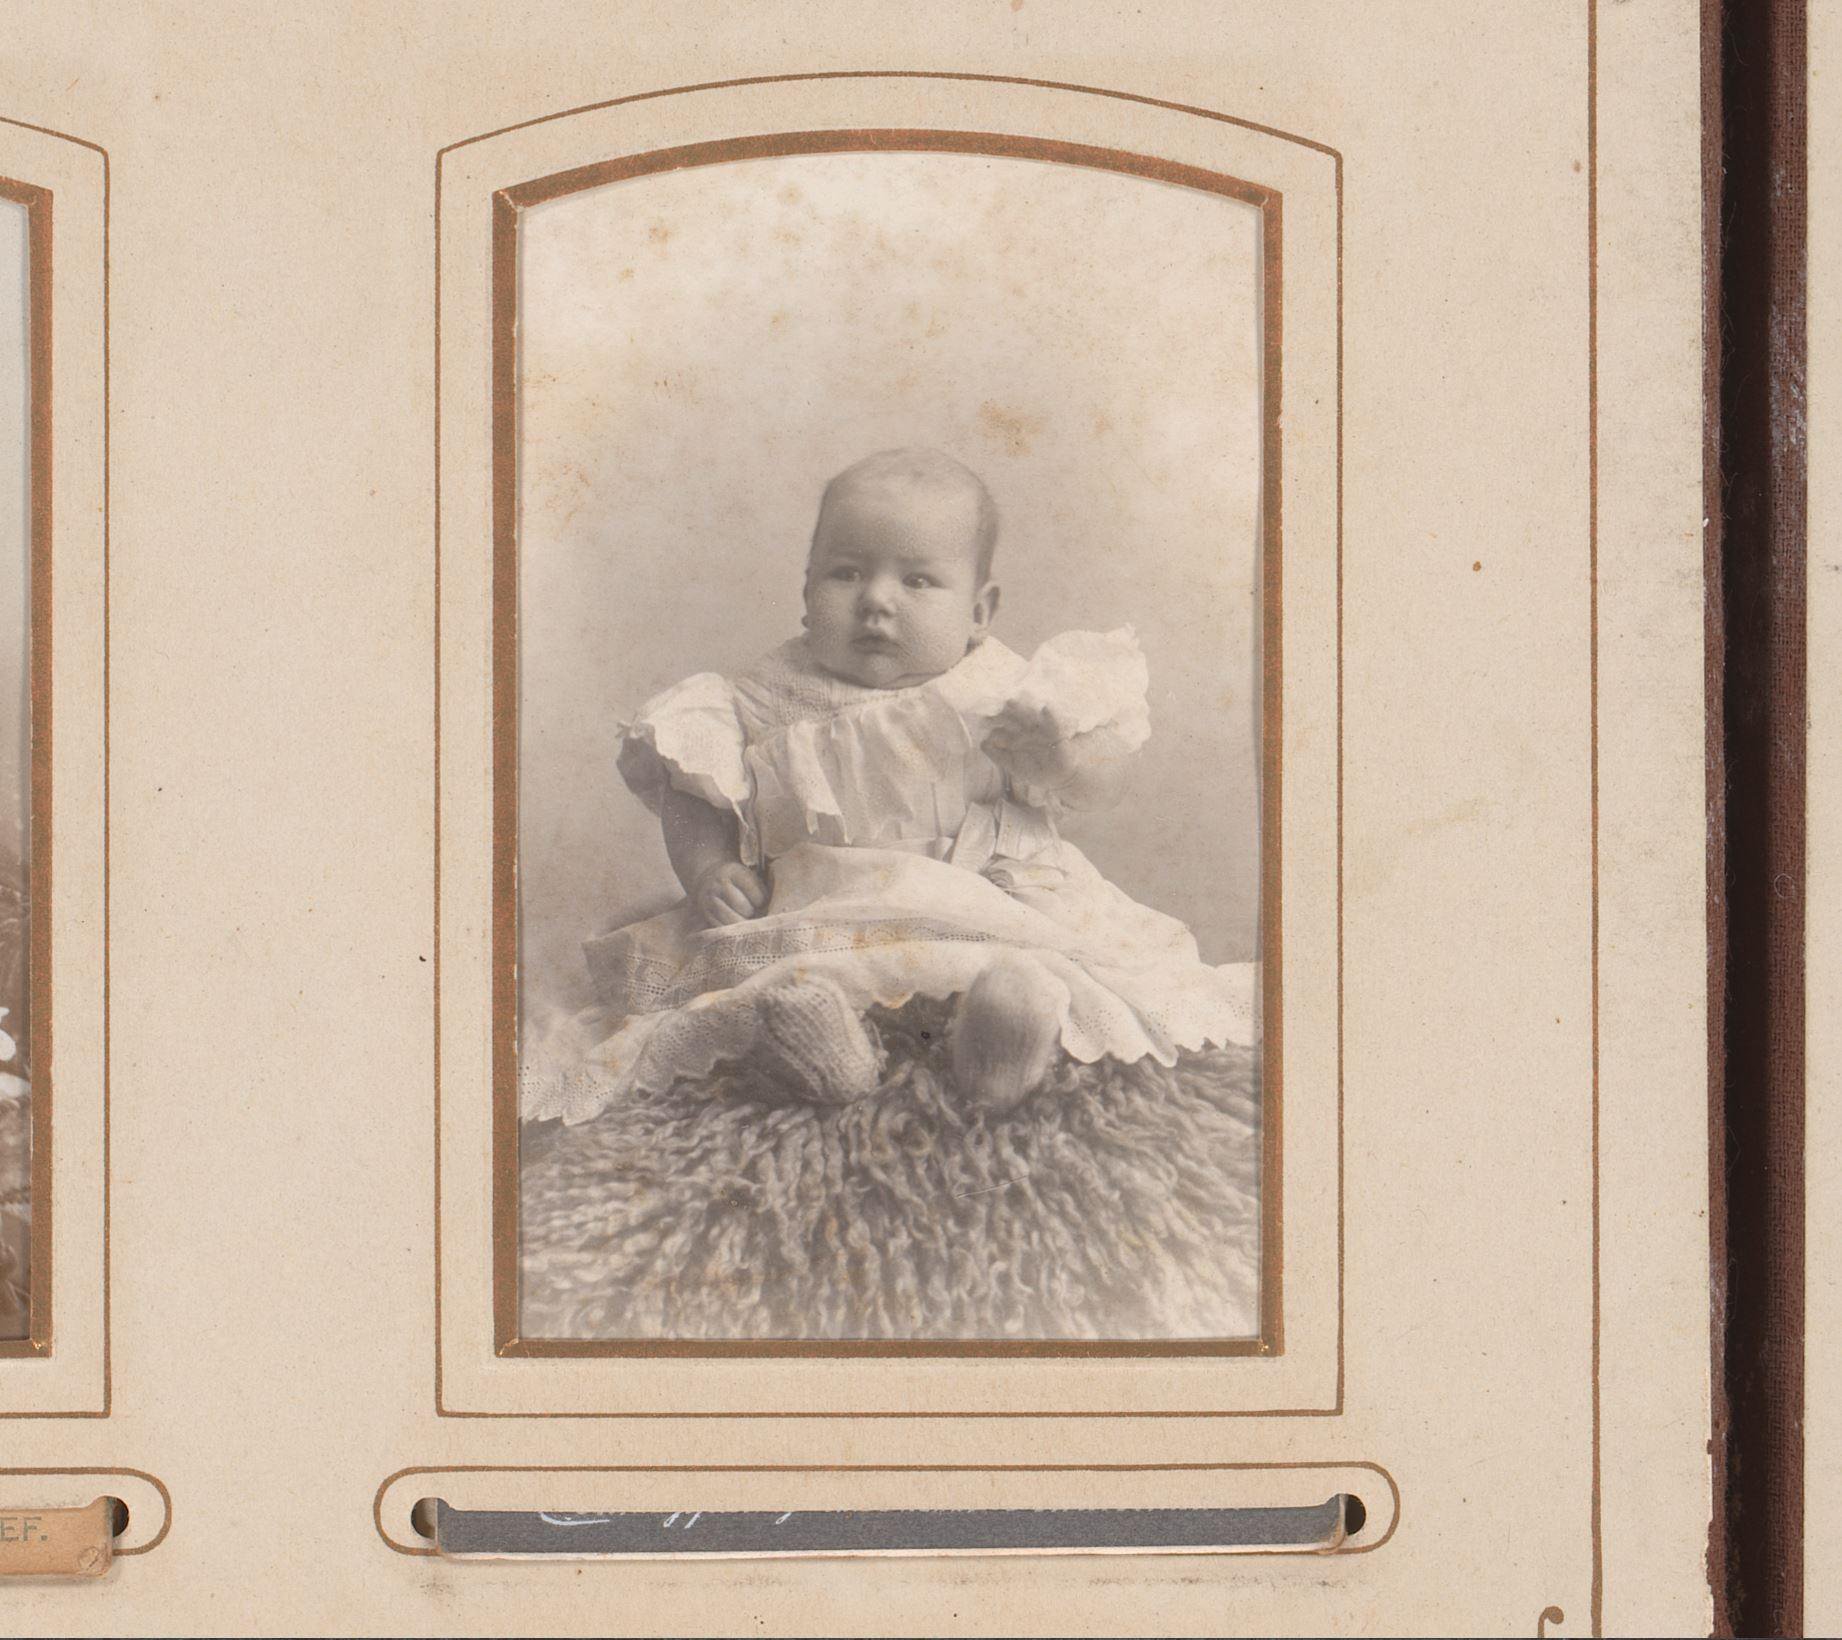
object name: album leaf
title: Portret van een zittende baby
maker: h.c. de graaff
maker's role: fotograaf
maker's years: 1853-1932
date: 1890-1920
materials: cardboard, photographic support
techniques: collodion silver print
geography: amsterdam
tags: confinement, birth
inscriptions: inscription: ‘Photographie Société anonyme/ Dir. H.C. de Graaff/ Koningsplein gebouw Kosmos/ Amsterdam’